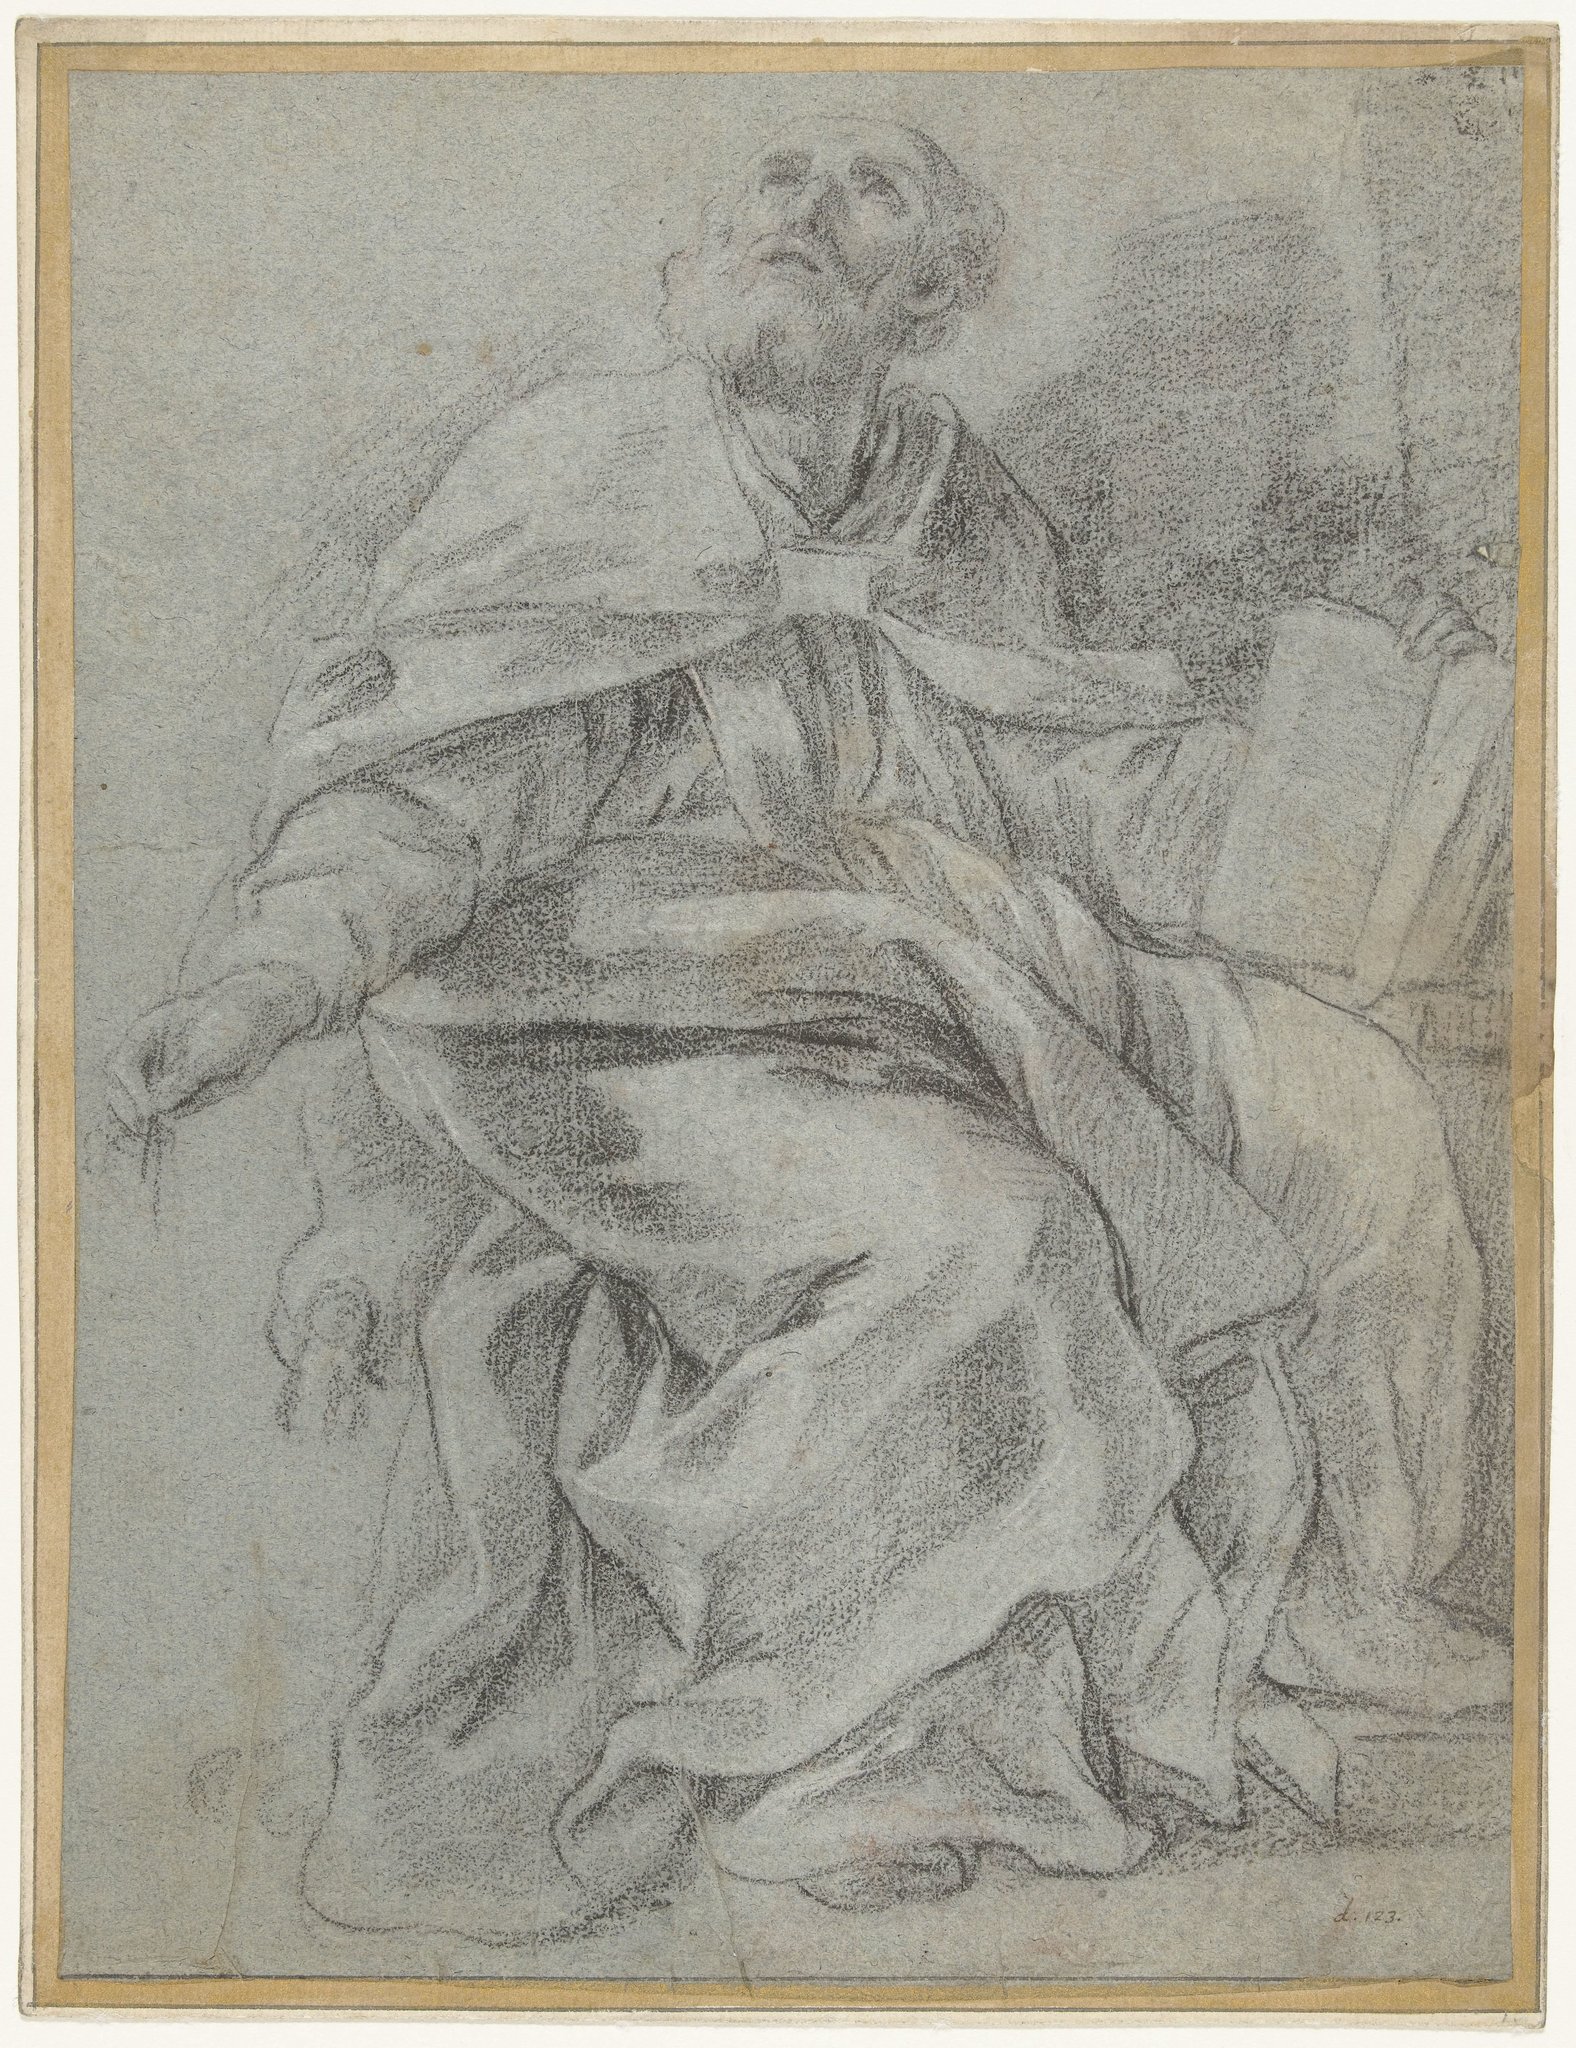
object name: drawing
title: De H. Hilarius, de Drieëenheid aanschouwende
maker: guillaume courtois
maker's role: draughtsman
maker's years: 1628-1679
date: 1654-1656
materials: chalk, paper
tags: hilary (hilarius), bishop of poitiers; possible attributes: serpent(s) - vision(s), mystic marriage of male saint